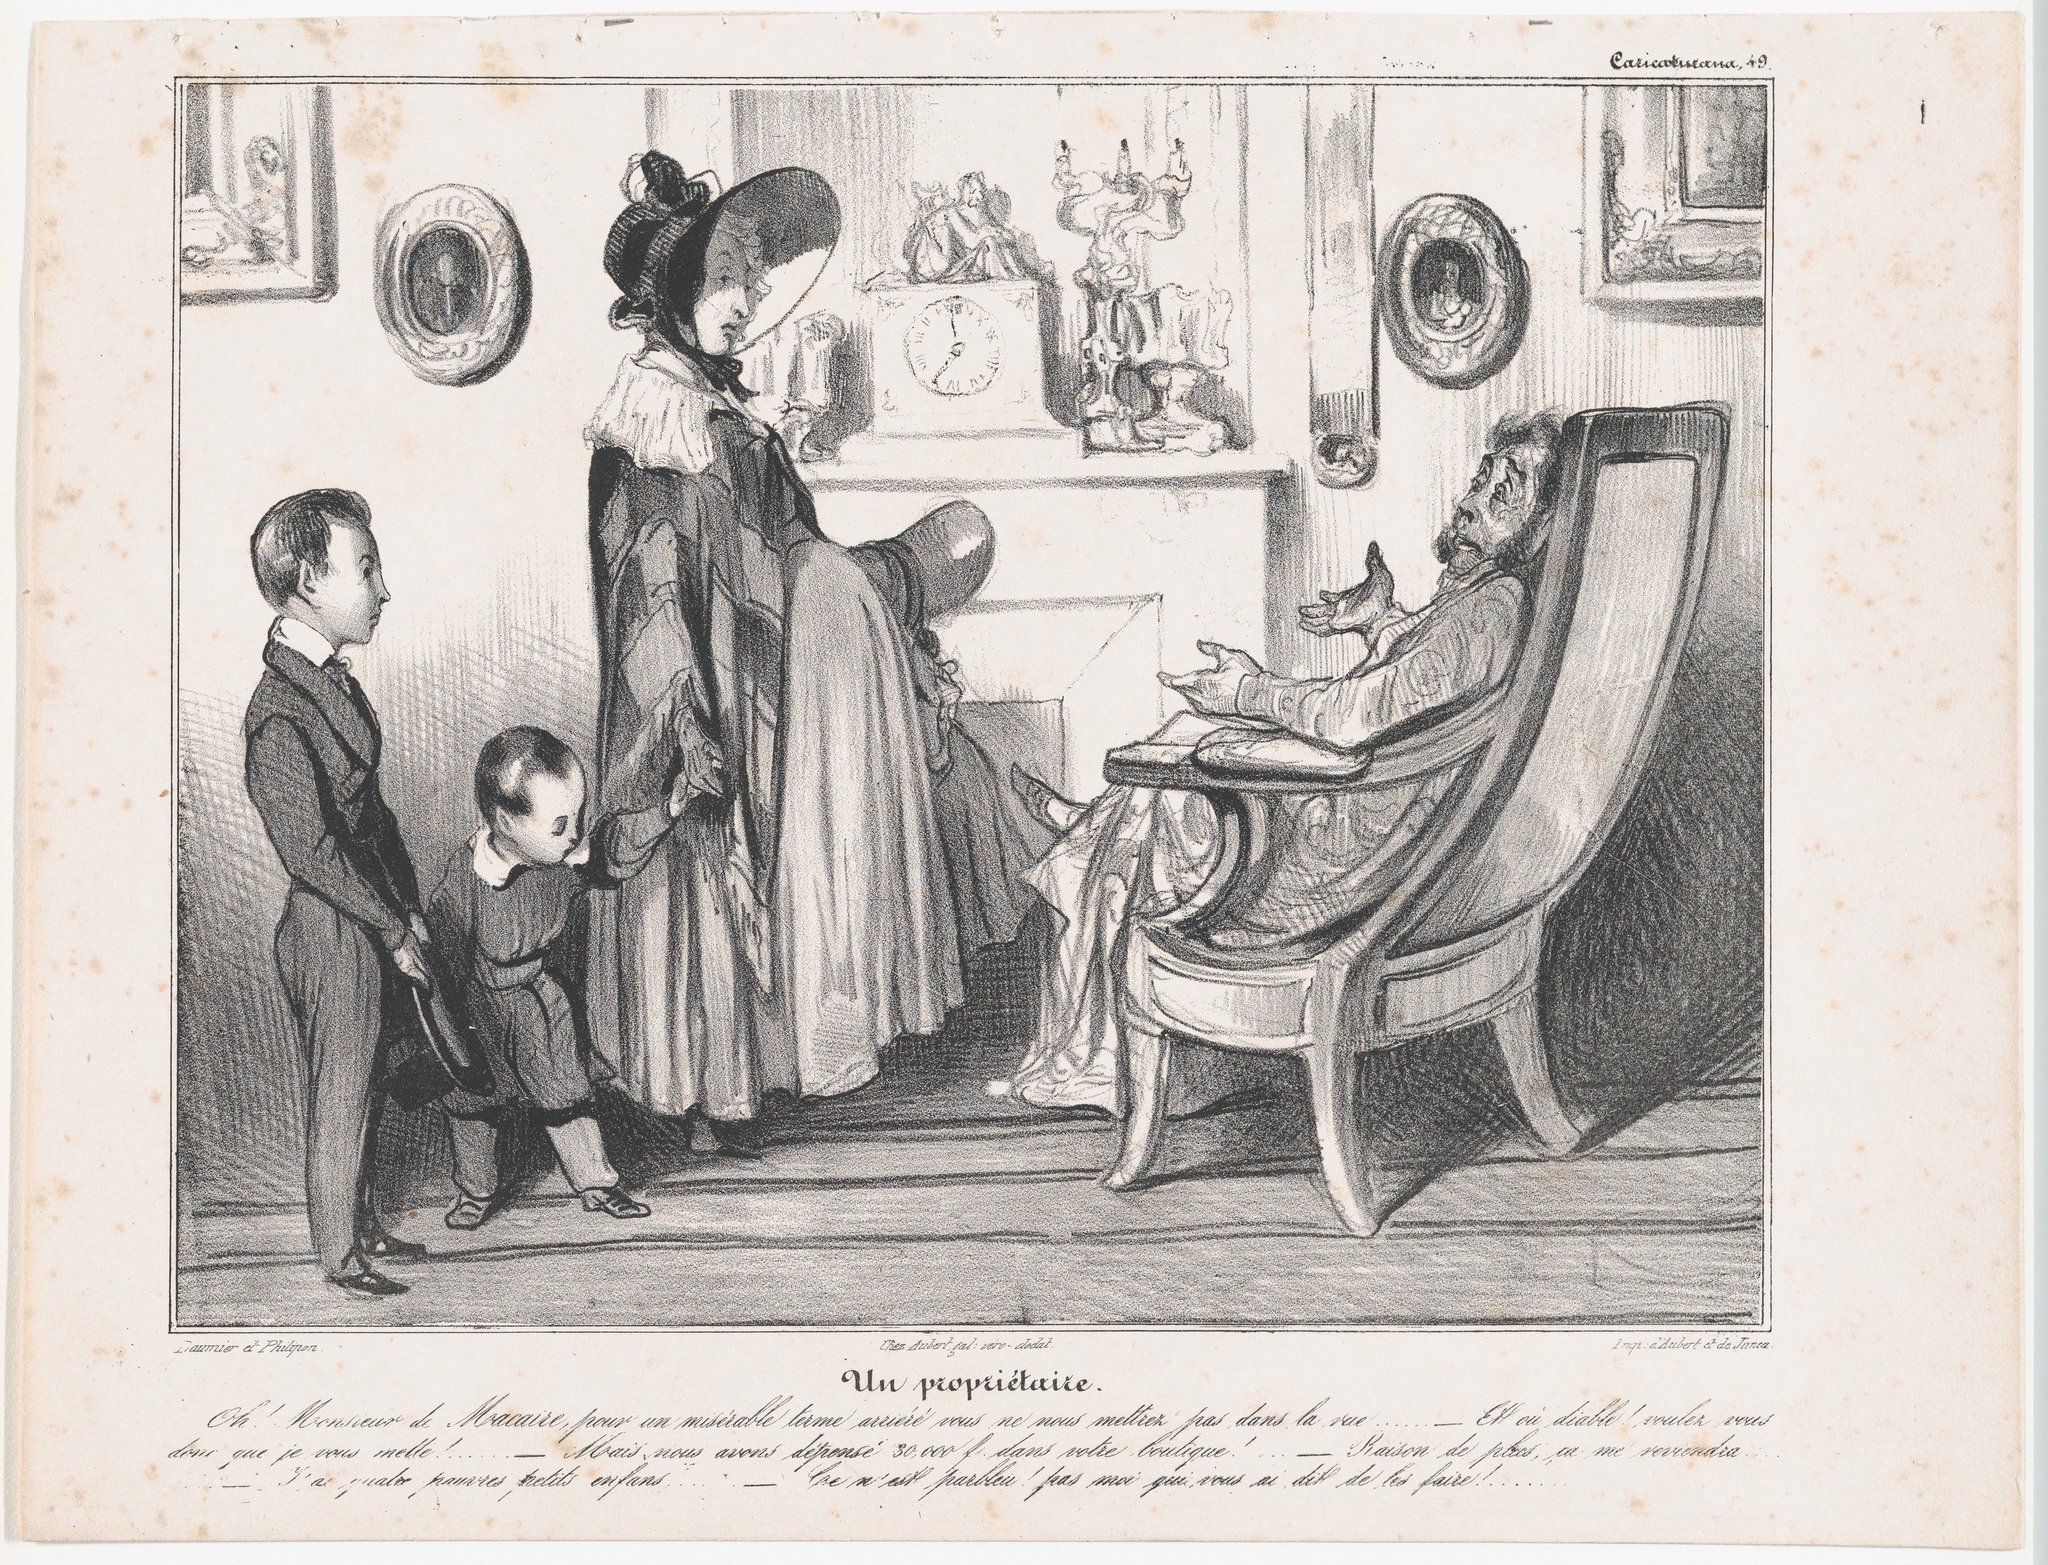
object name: print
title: Plate 49: A Landlord, from 'Caricaturana,' published in Les Robert Macaires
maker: honoré daumier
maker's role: artist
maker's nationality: french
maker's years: 1808-1879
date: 1838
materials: paper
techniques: lithograph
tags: children,boys,men,women